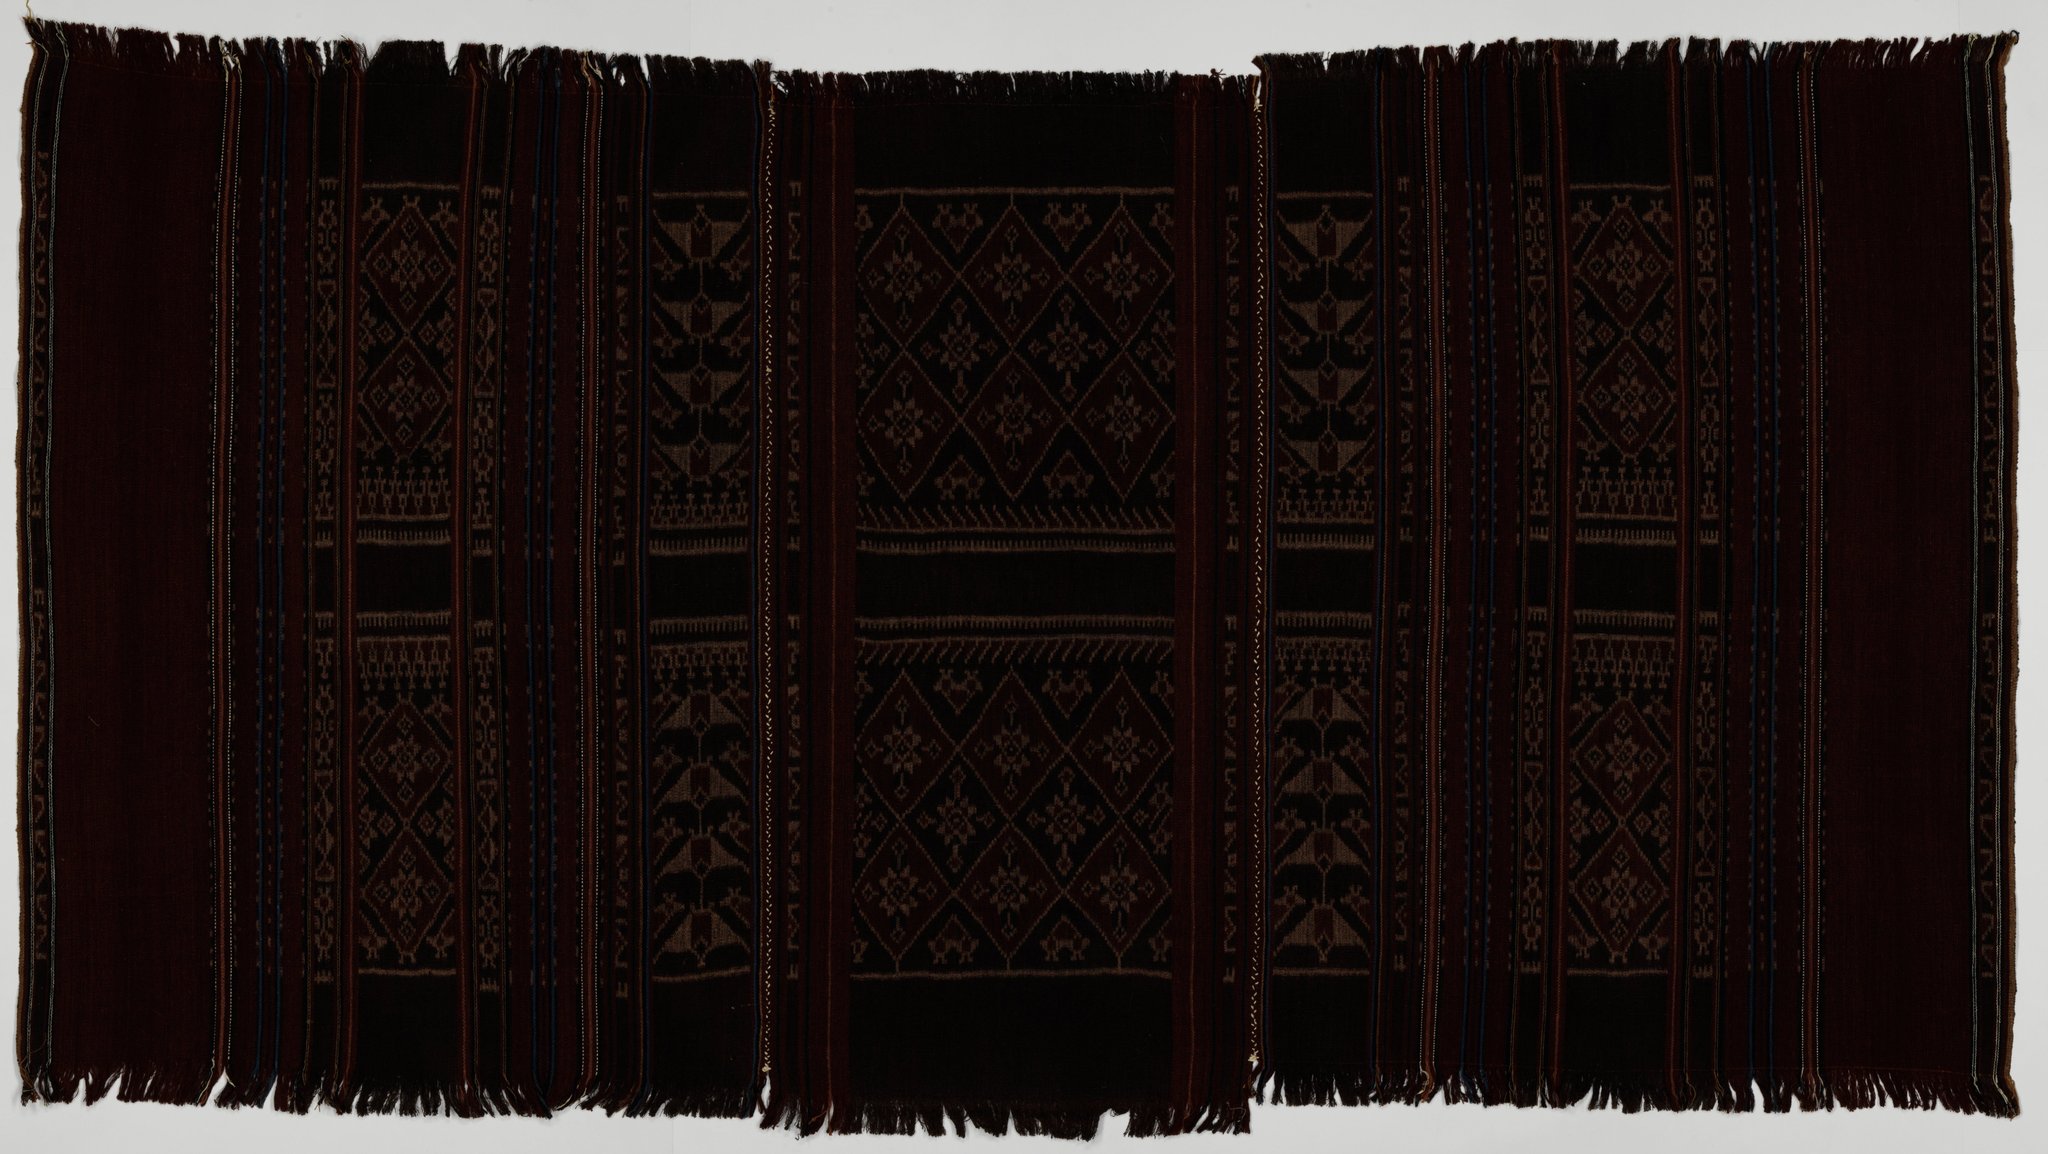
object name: cloth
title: Doek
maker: Anonymous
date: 1900-1949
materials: cotton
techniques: weave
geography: flores